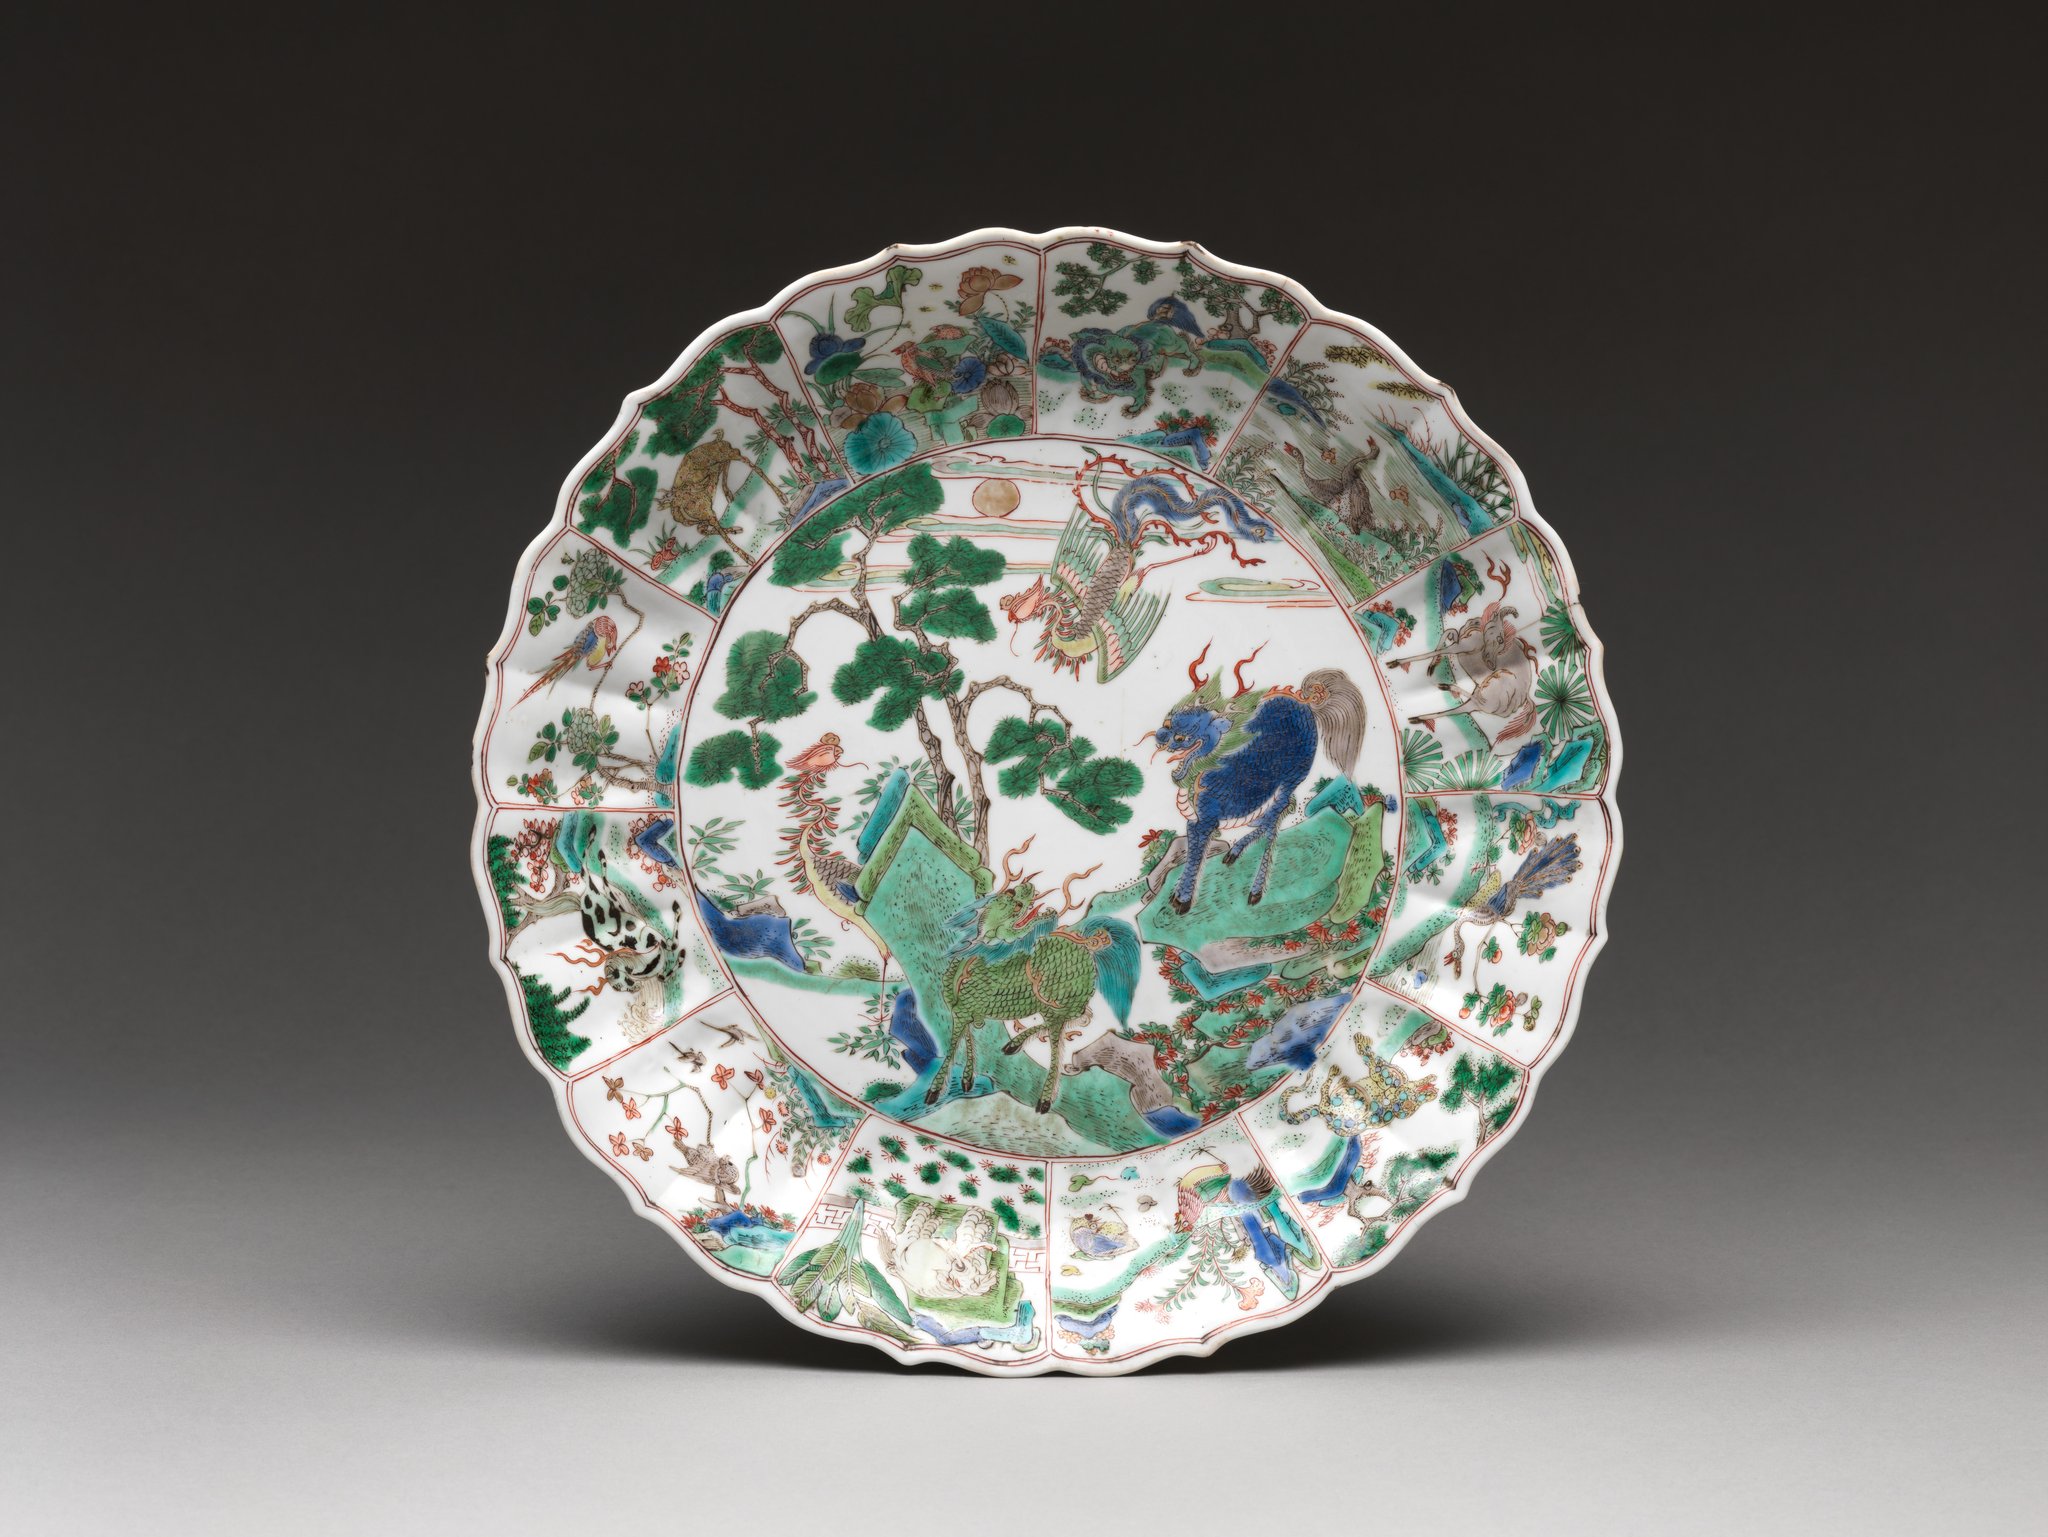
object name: plate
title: Plate with Phoenix and Mythical Qilin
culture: chinese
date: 1678-1688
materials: enamel, glaze, porcelain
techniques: painting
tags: mythical creatures,trees